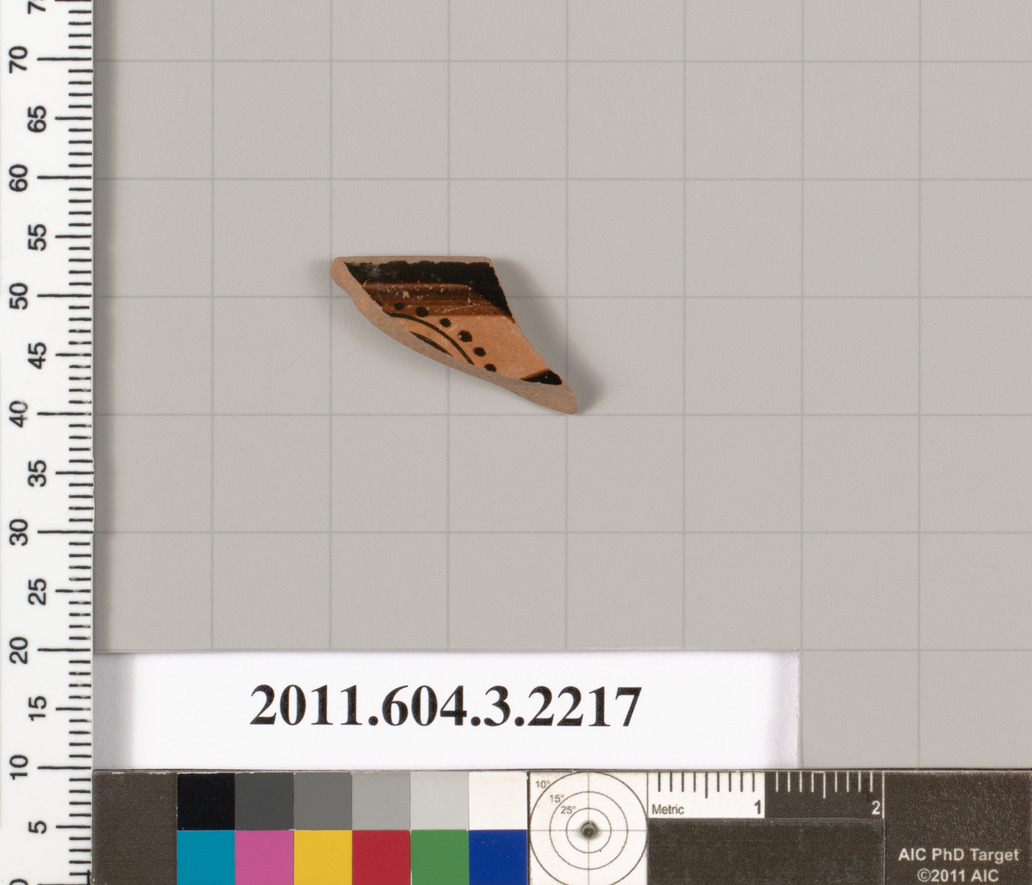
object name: kylix fragment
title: Terracotta rim fragment of a kylix (drinking cup)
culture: greek, attic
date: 525-501 BCE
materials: terracotta